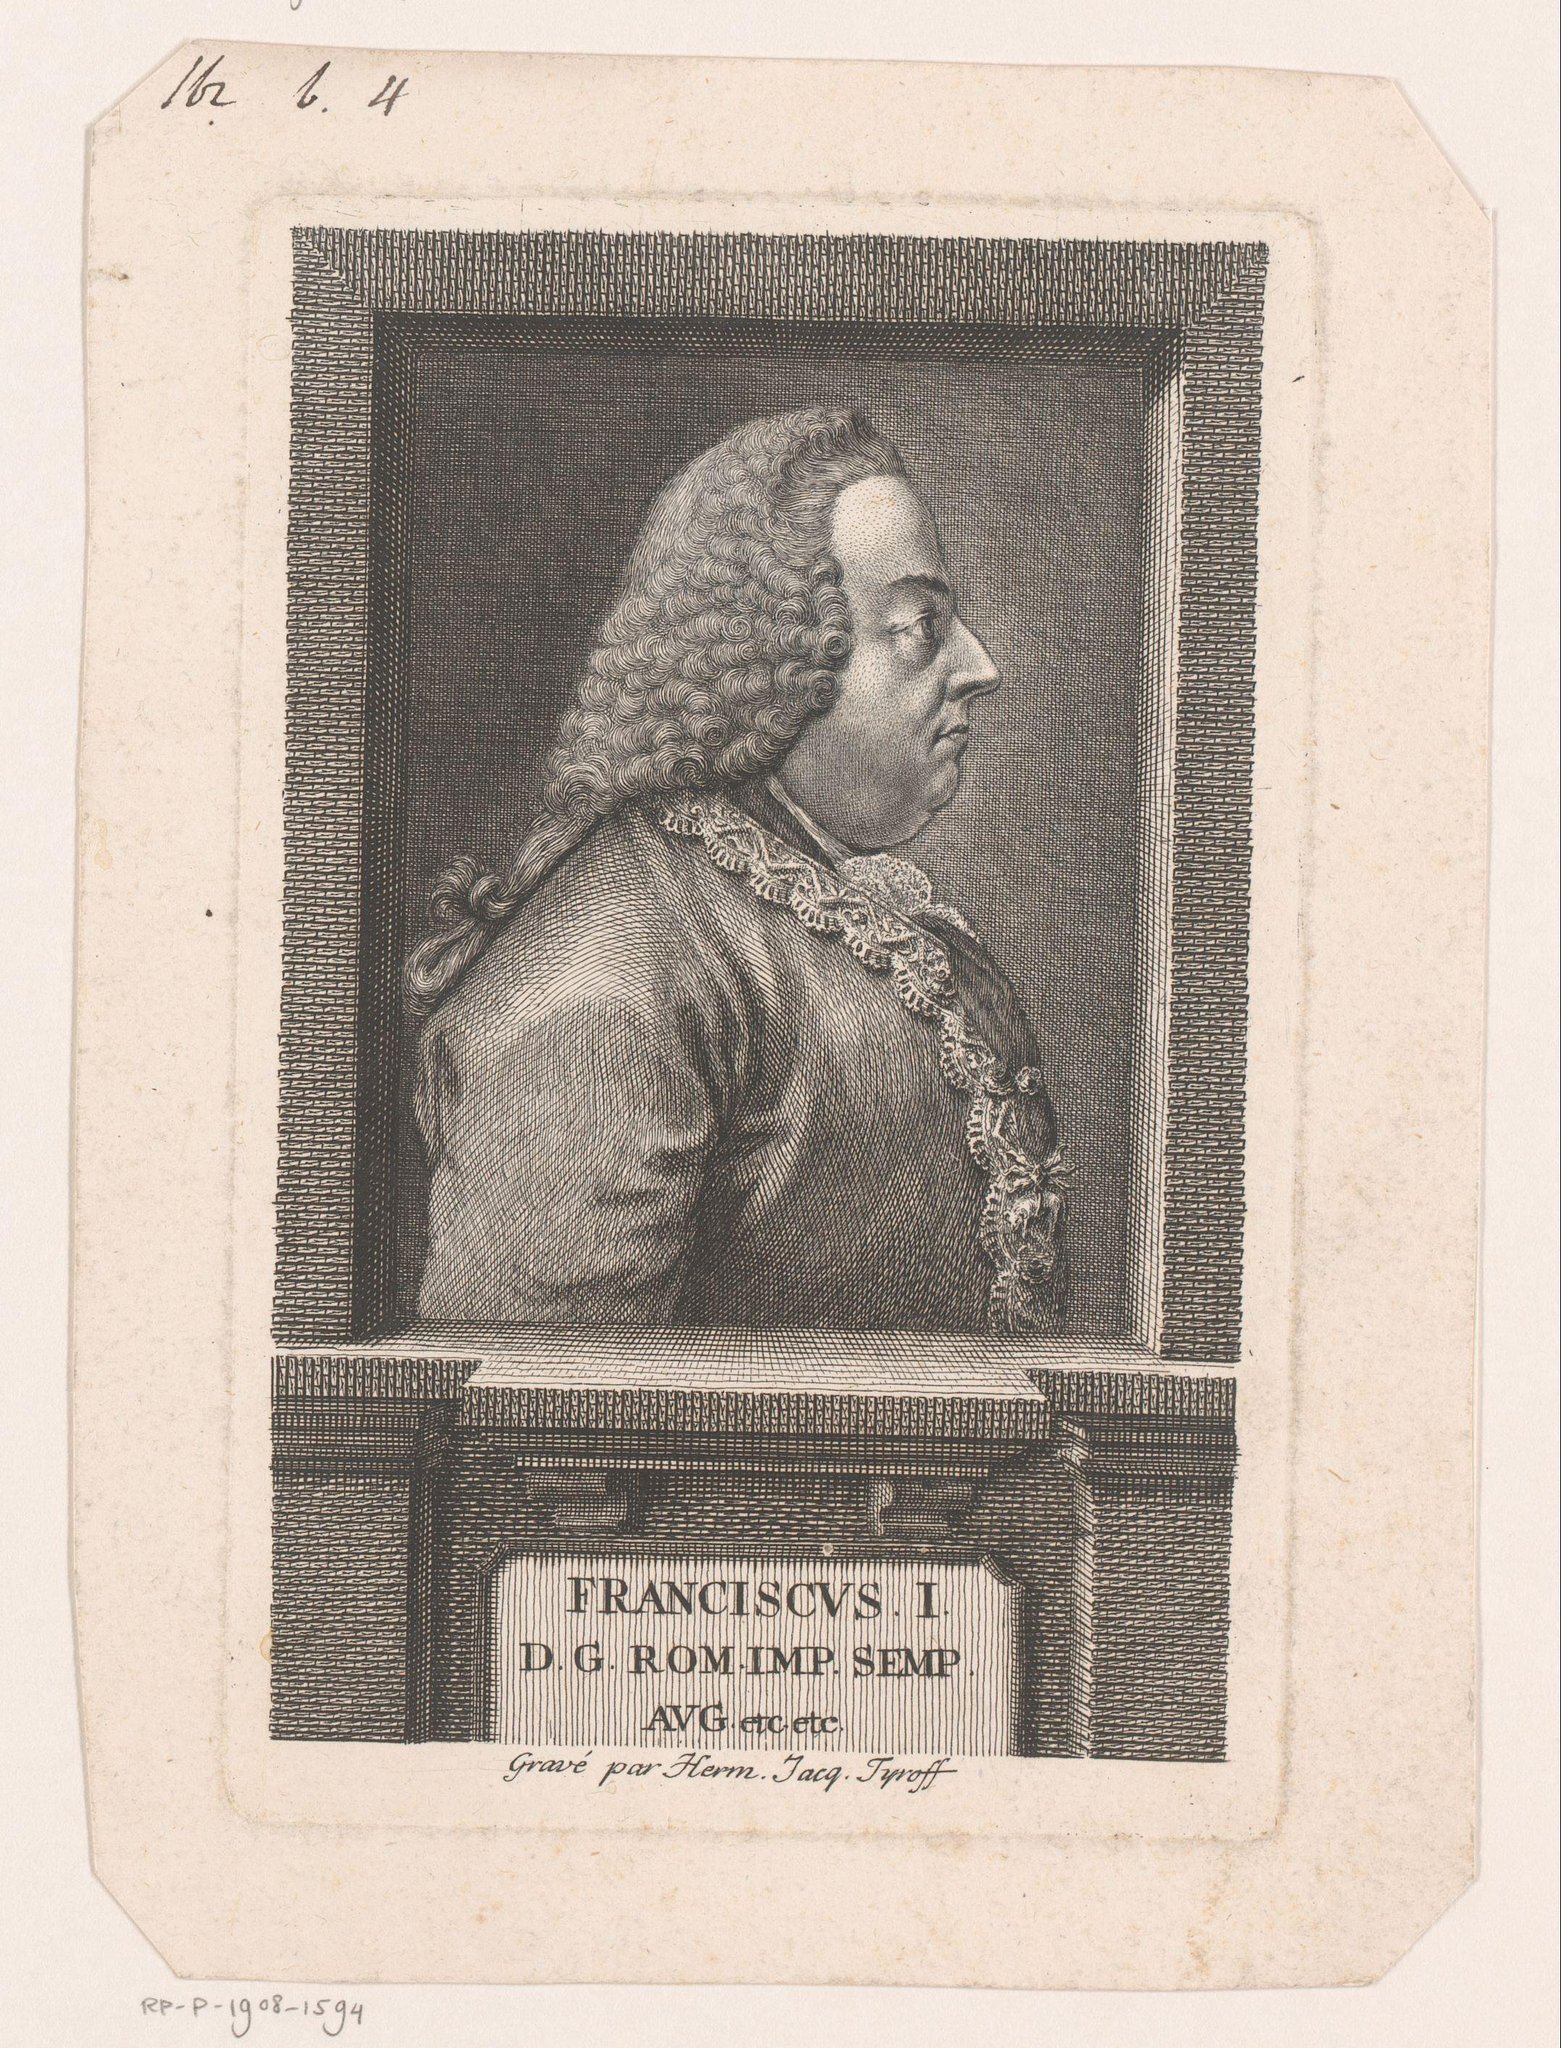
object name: print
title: Portret van Frans I Stefan, Duits keizer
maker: hermann jakob tyroff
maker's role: print maker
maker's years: 1742-1809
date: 1752-1798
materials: paper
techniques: etching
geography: germany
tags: frans i stefan (duits keizer), historical persons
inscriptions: collector's mark: Lugt 2228, inscription: ‘162 6 4’